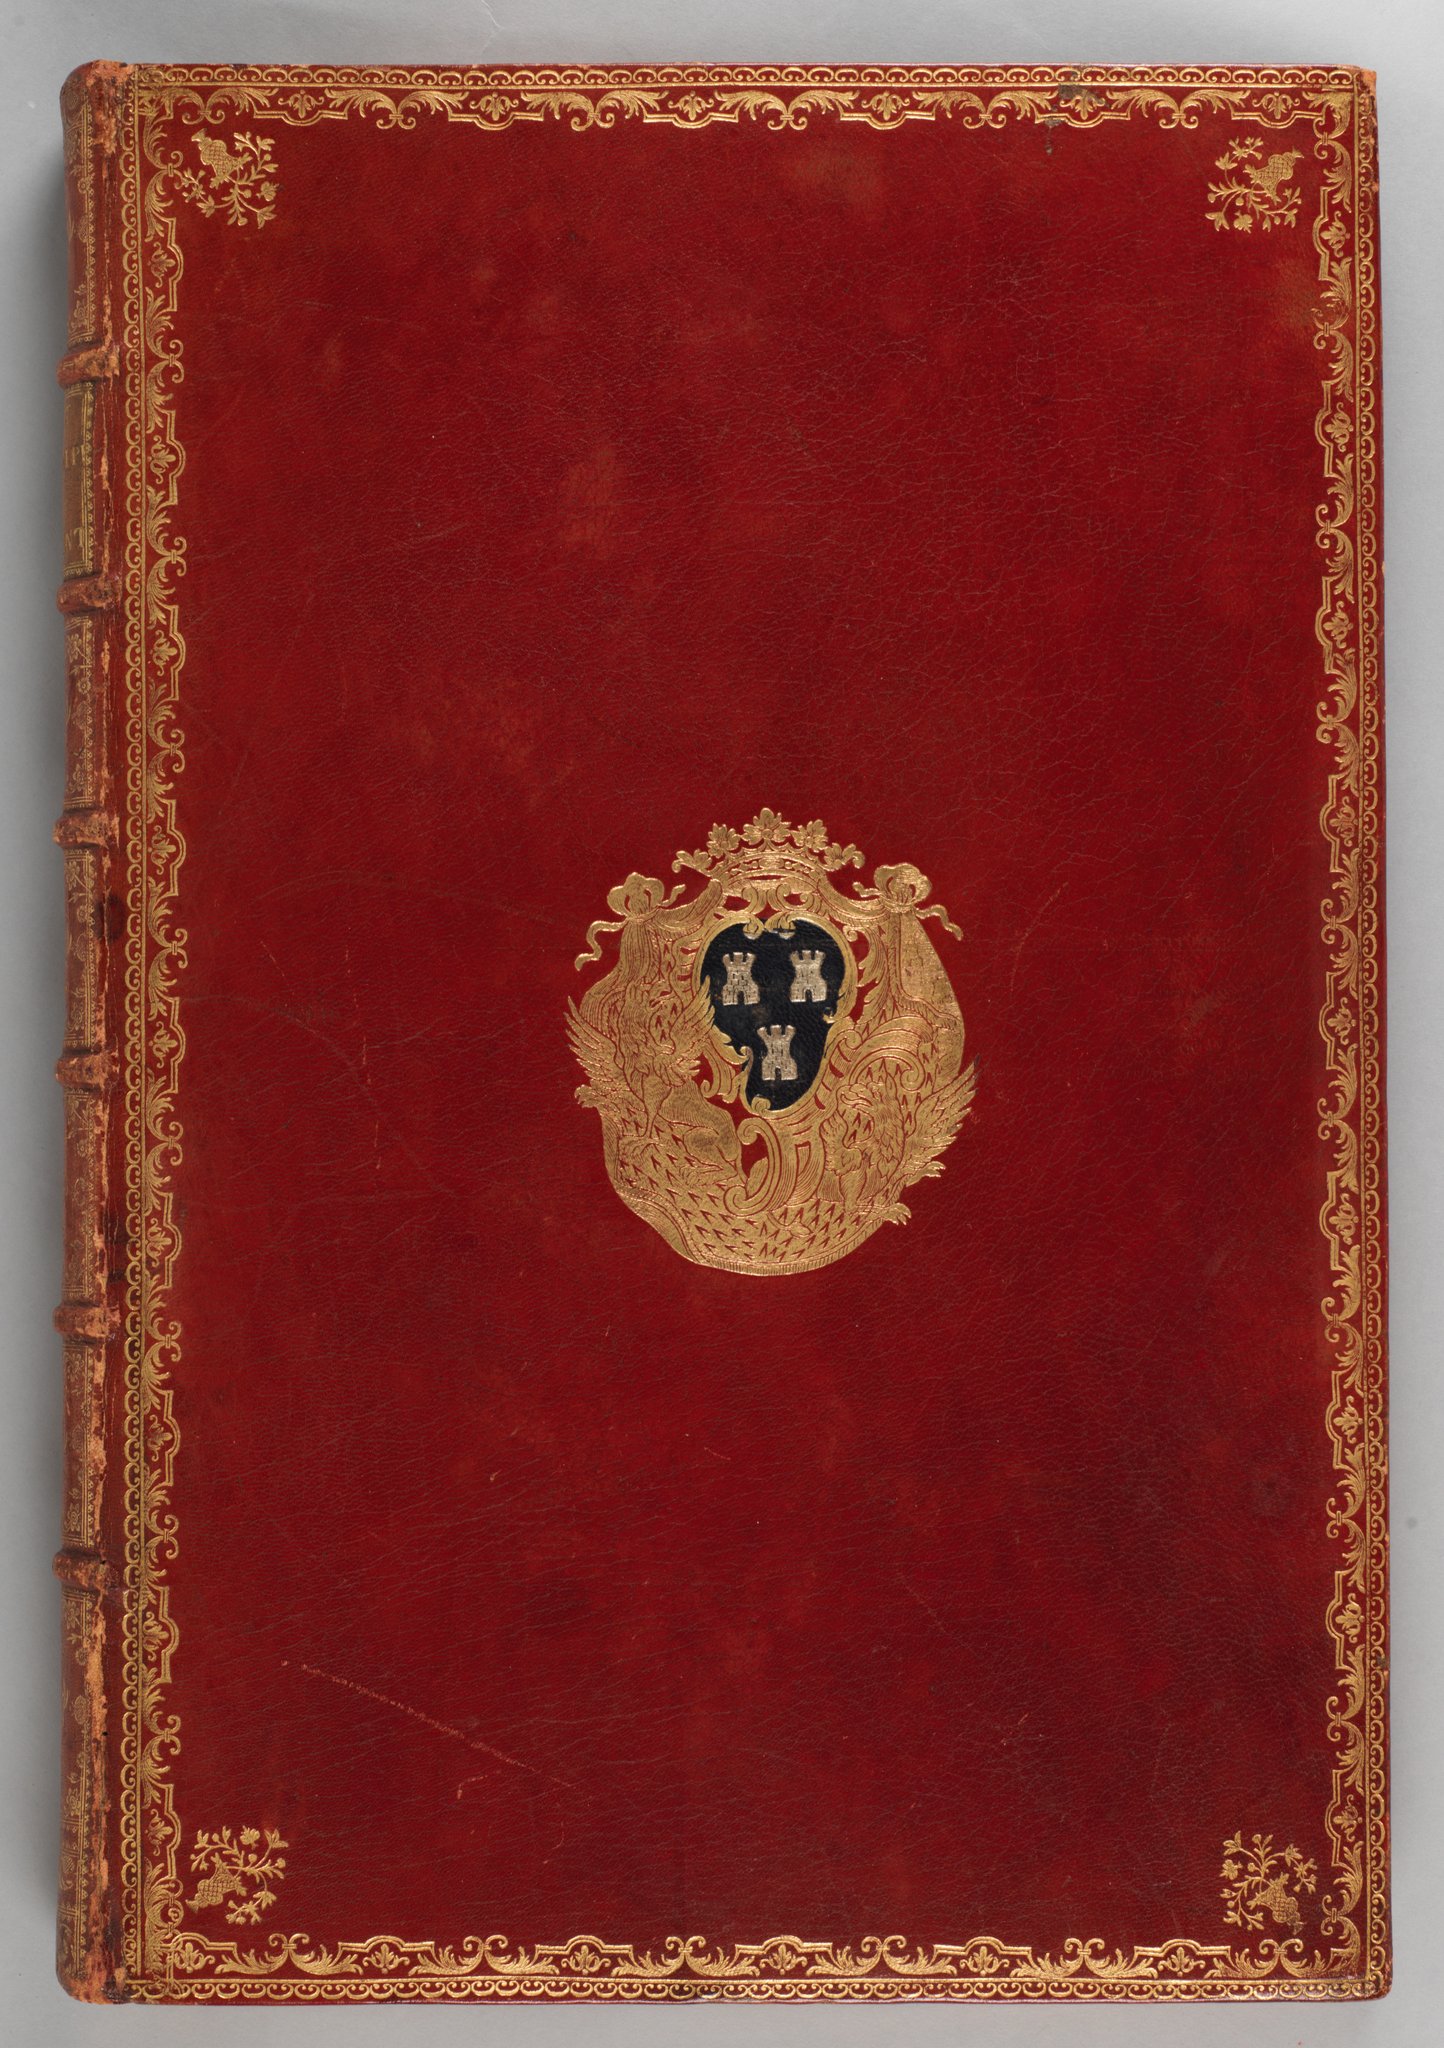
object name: book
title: Explication des cent estampes qui représentent différentes nations du Levant avec de nouvelles estampes de cérémonies Turques qui ont aussi leurs explications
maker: leonardus quesi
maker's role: maker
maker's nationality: french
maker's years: 1650-1750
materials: leather, paper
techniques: bookbinding, engraving, hand coloring